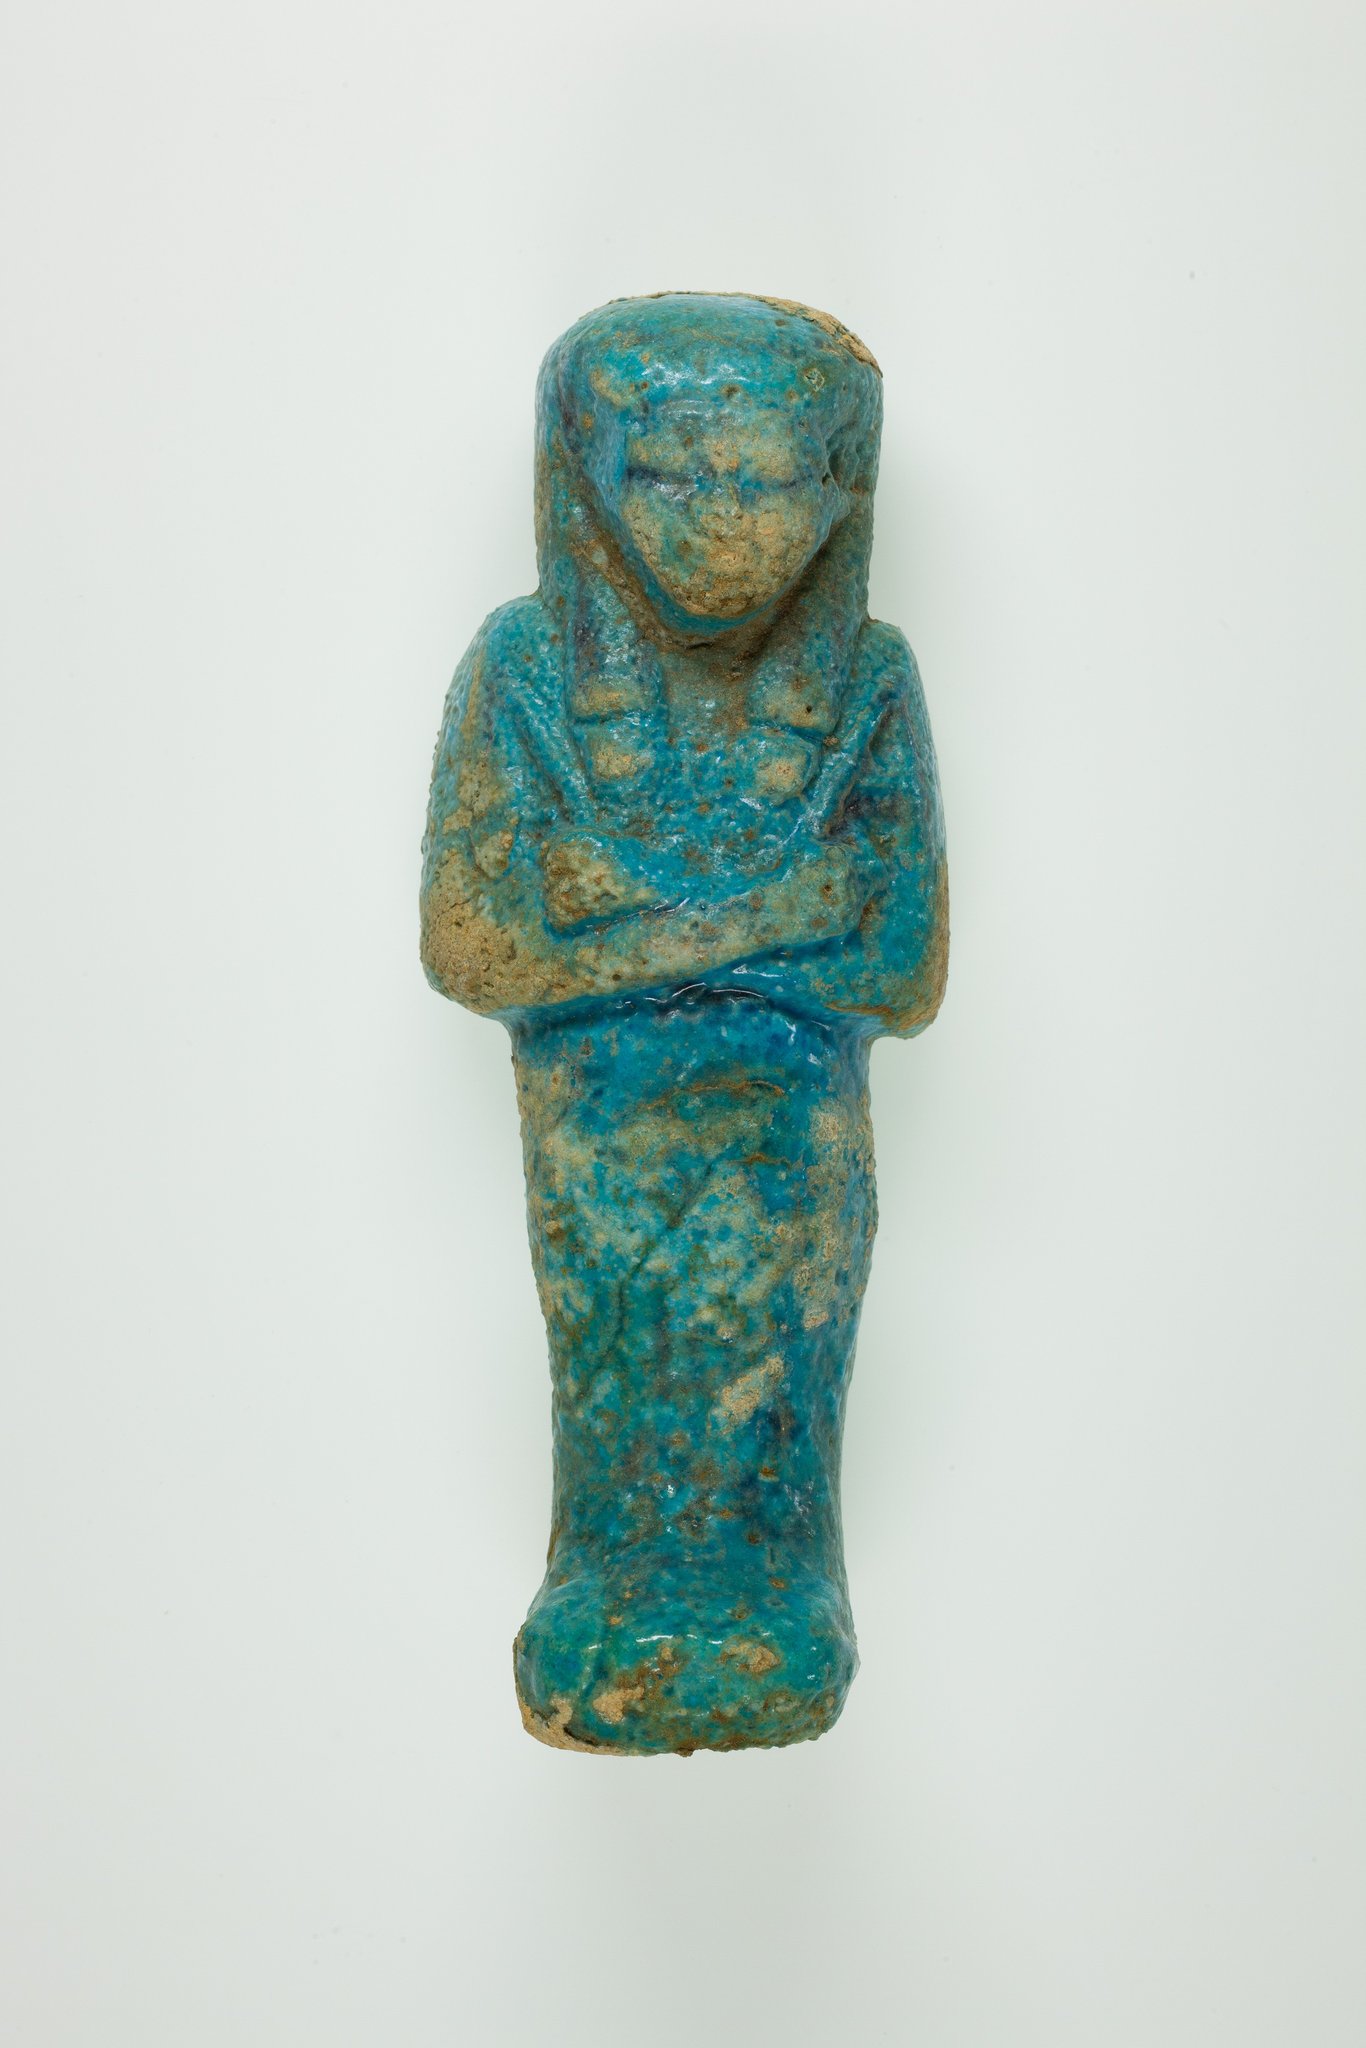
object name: worker shabti, henettawy c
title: Worker Shabti of Henettawy (C), Daughter of Isetemkheb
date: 990-970 BCE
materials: faience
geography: egypt